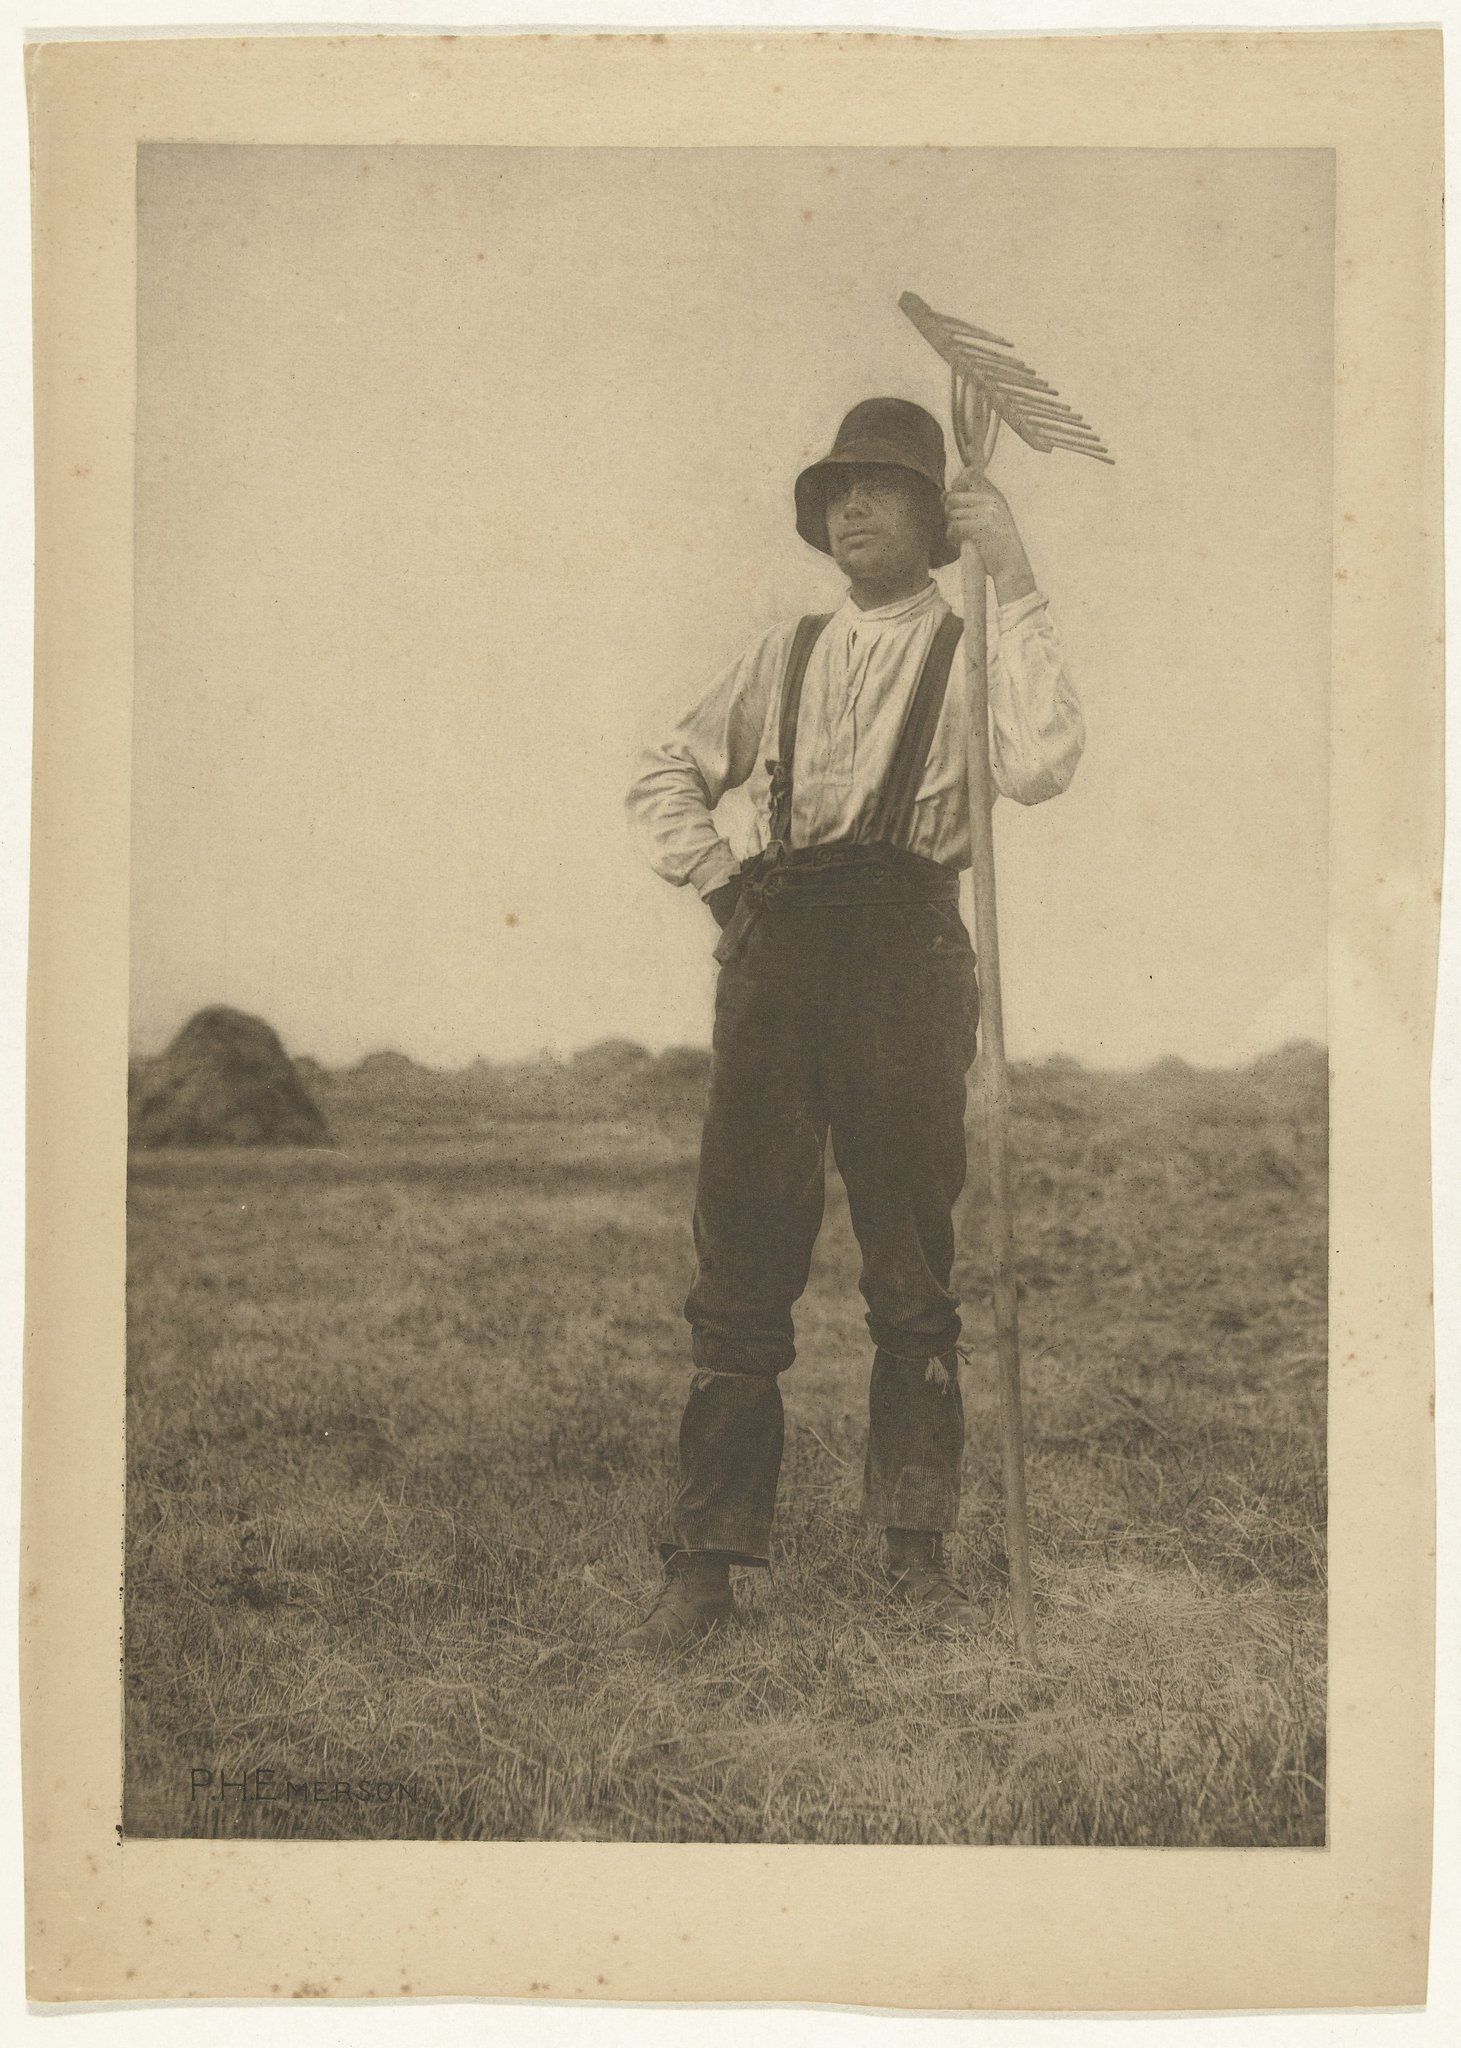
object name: photomechanical print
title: Landarbeider met hooihark in Norfolk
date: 1883-1888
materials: cardboard, paper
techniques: photoaquatint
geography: norfolk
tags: agricultural products and by-products: hay